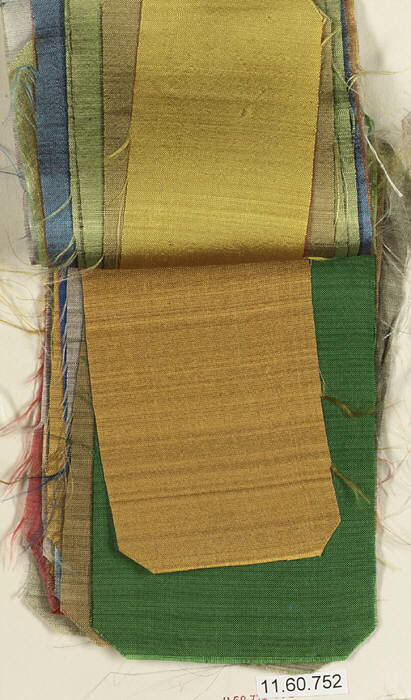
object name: sample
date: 1801-1833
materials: silk